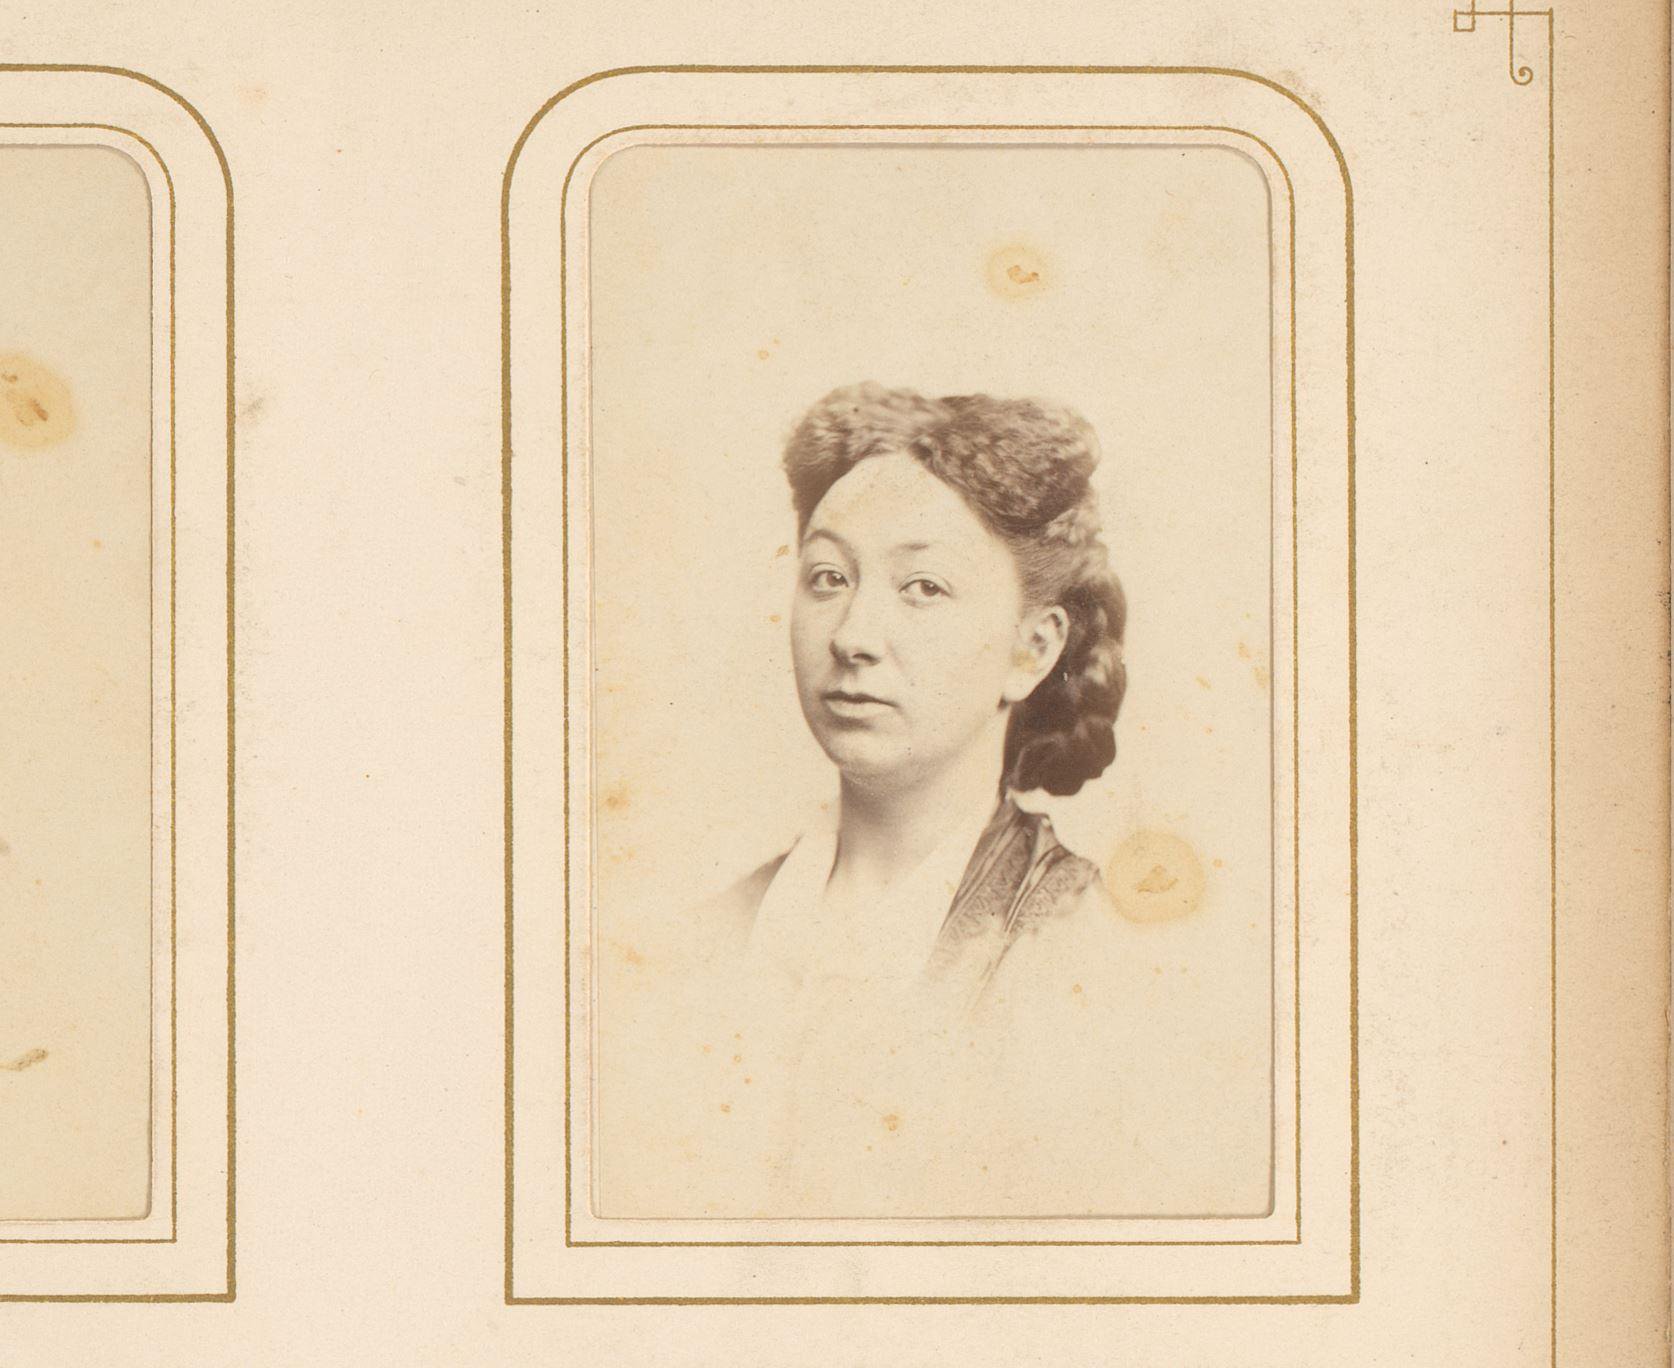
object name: carte de visite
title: Portret van een vrouw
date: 1860-1900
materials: cardboard, photographic support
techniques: albumen print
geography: brussels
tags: historical persons - bb - woman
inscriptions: inscription: ‘DECHAMPS & Cie/ PHOTOGRAPHES BREVETÉS,/ 14, Place Ste Gudule, 14,/ BRUXELLES.’